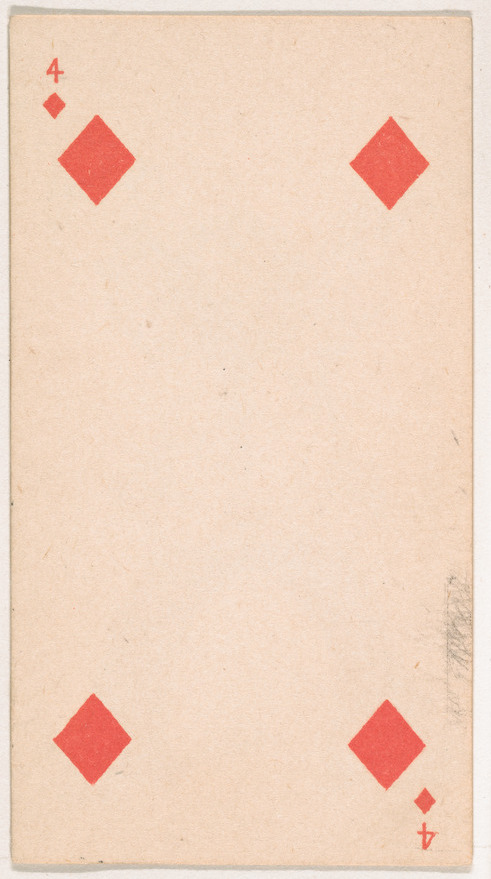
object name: print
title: Four of Diamonds, from the Transparent Playing Cards series (N220) issued by Kinney Bros.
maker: kinney brothers tobacco company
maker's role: publisher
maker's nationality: american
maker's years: 1869-2011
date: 1888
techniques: color lithograph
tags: playing cards